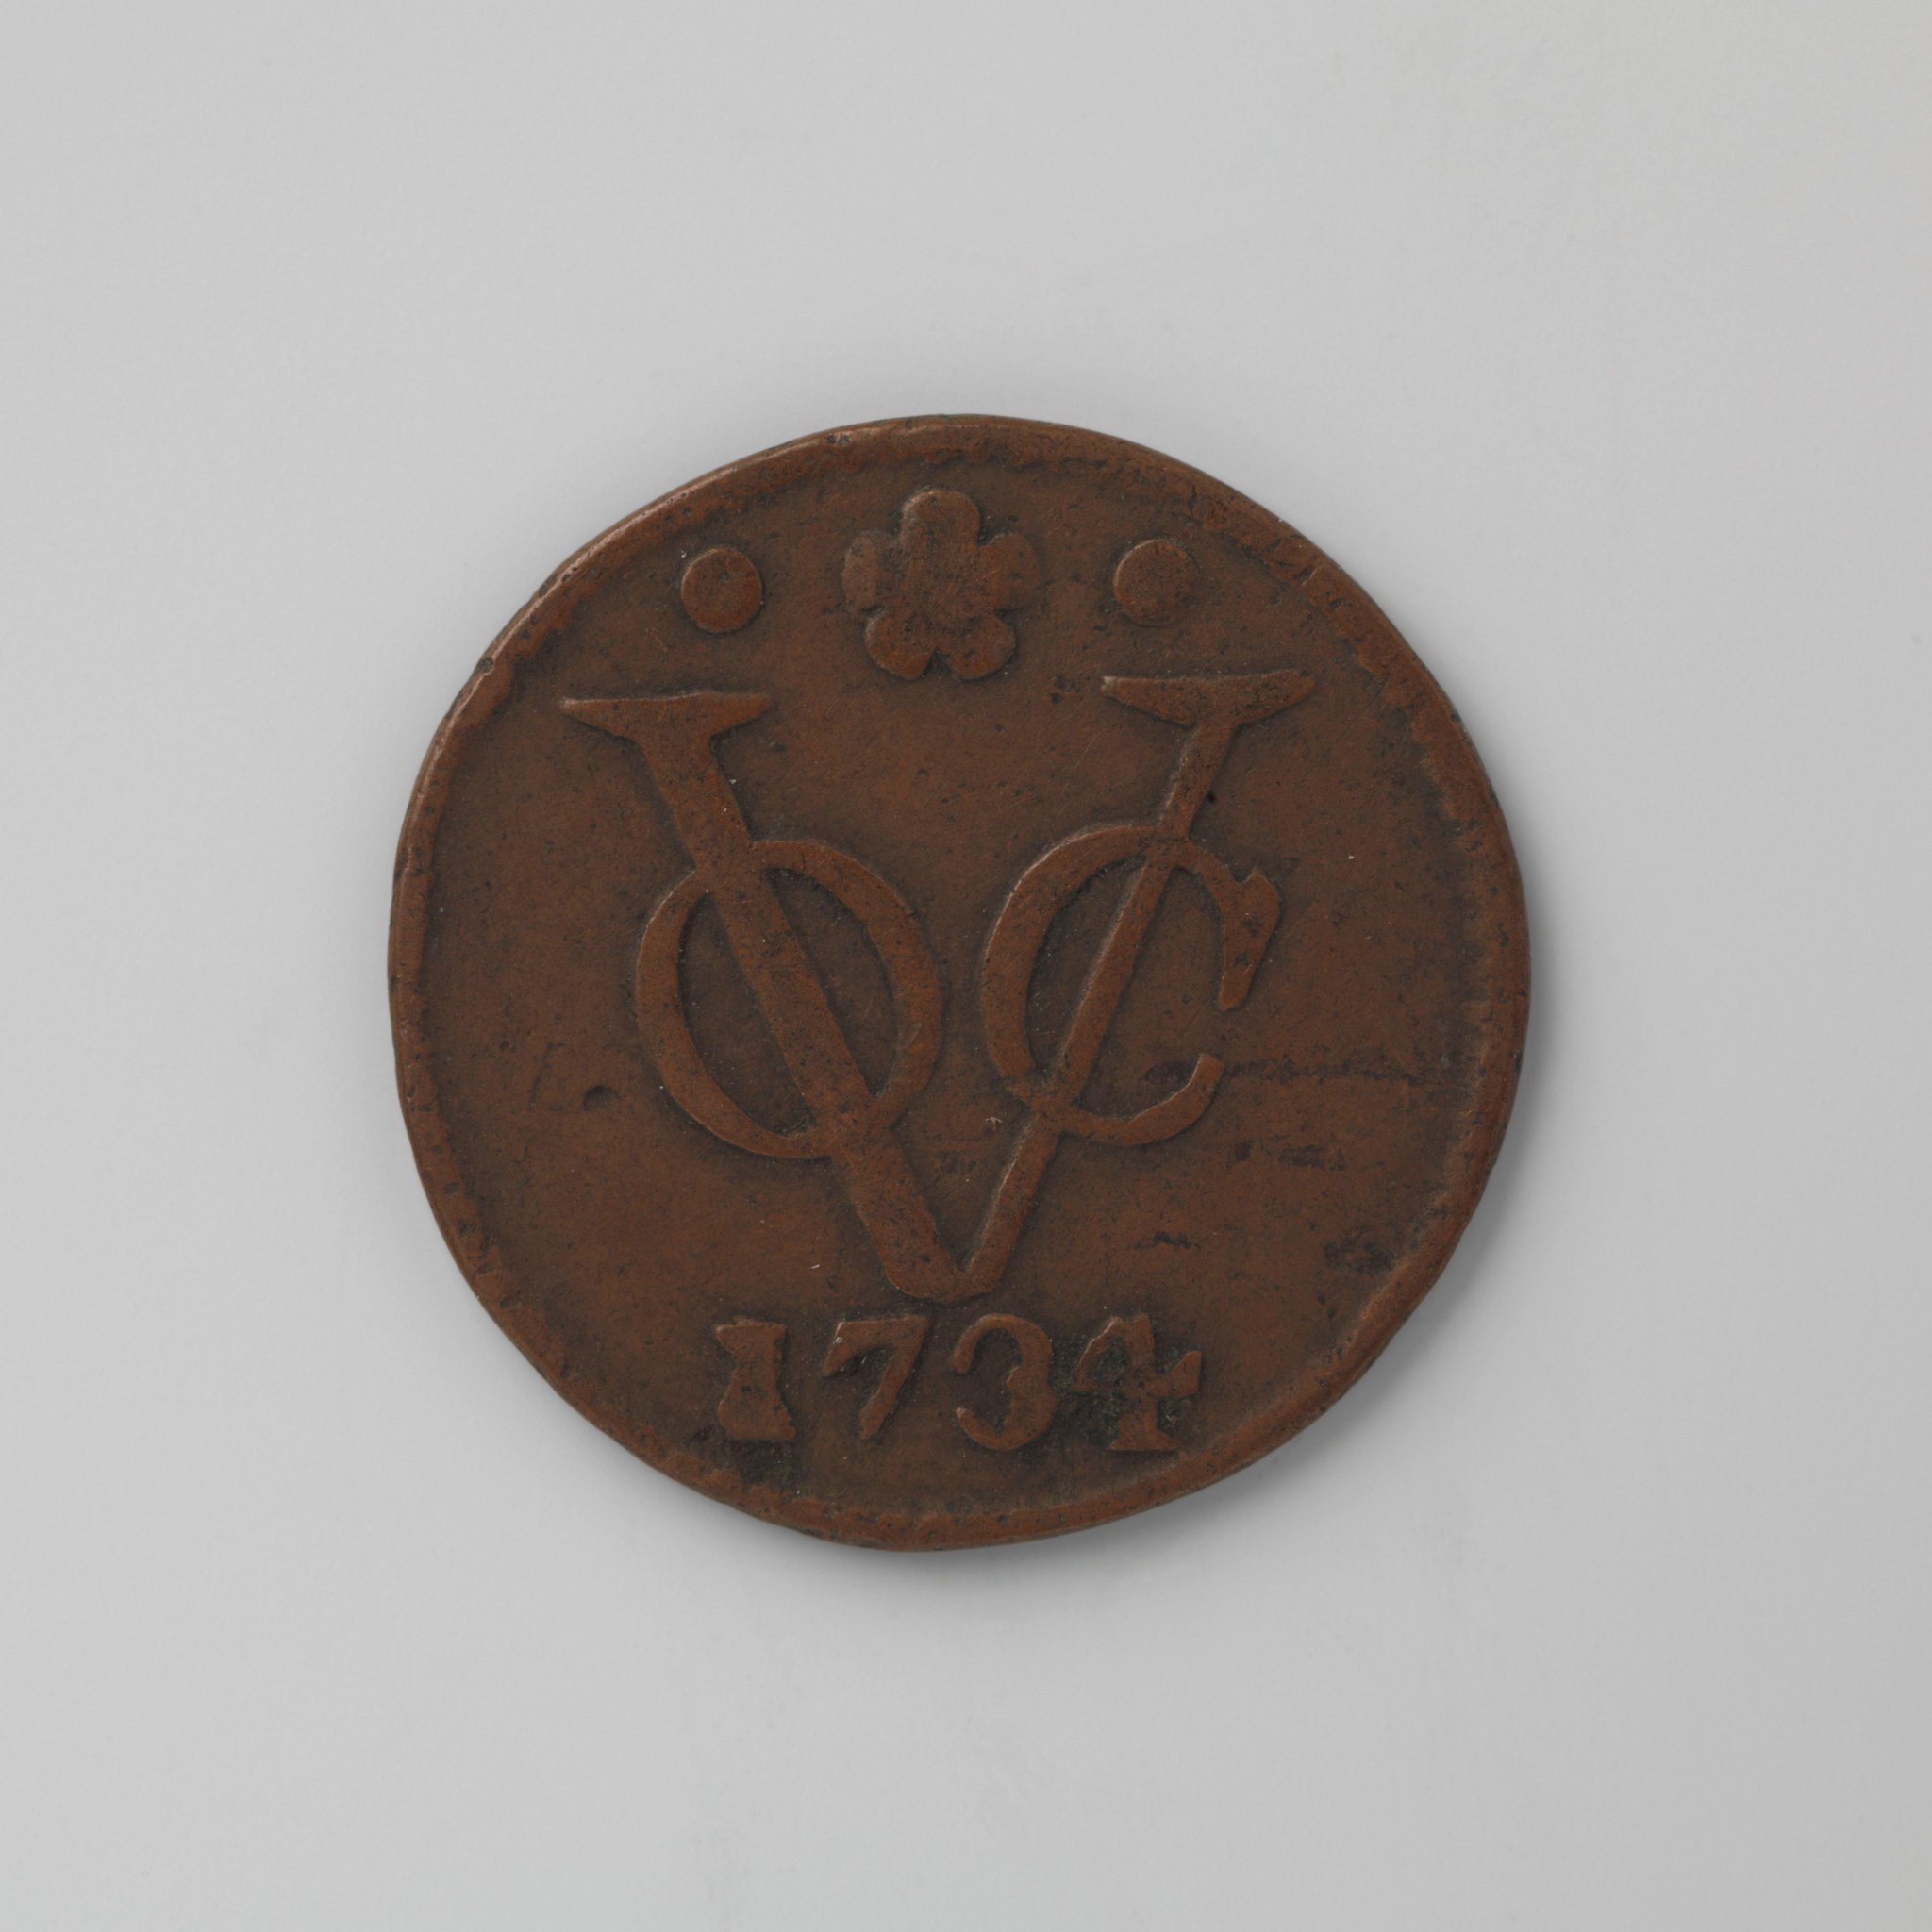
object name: coin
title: Duit van de VOC uit Holland, 1734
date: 1734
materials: copper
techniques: striking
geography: dordrecht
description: Koperen munt. Voorzijde: gekroond wapenschild van Holland. Keerzijde: monogram van de VOC, waarboven muntteken en waaronder jaartal. Gladde rand.